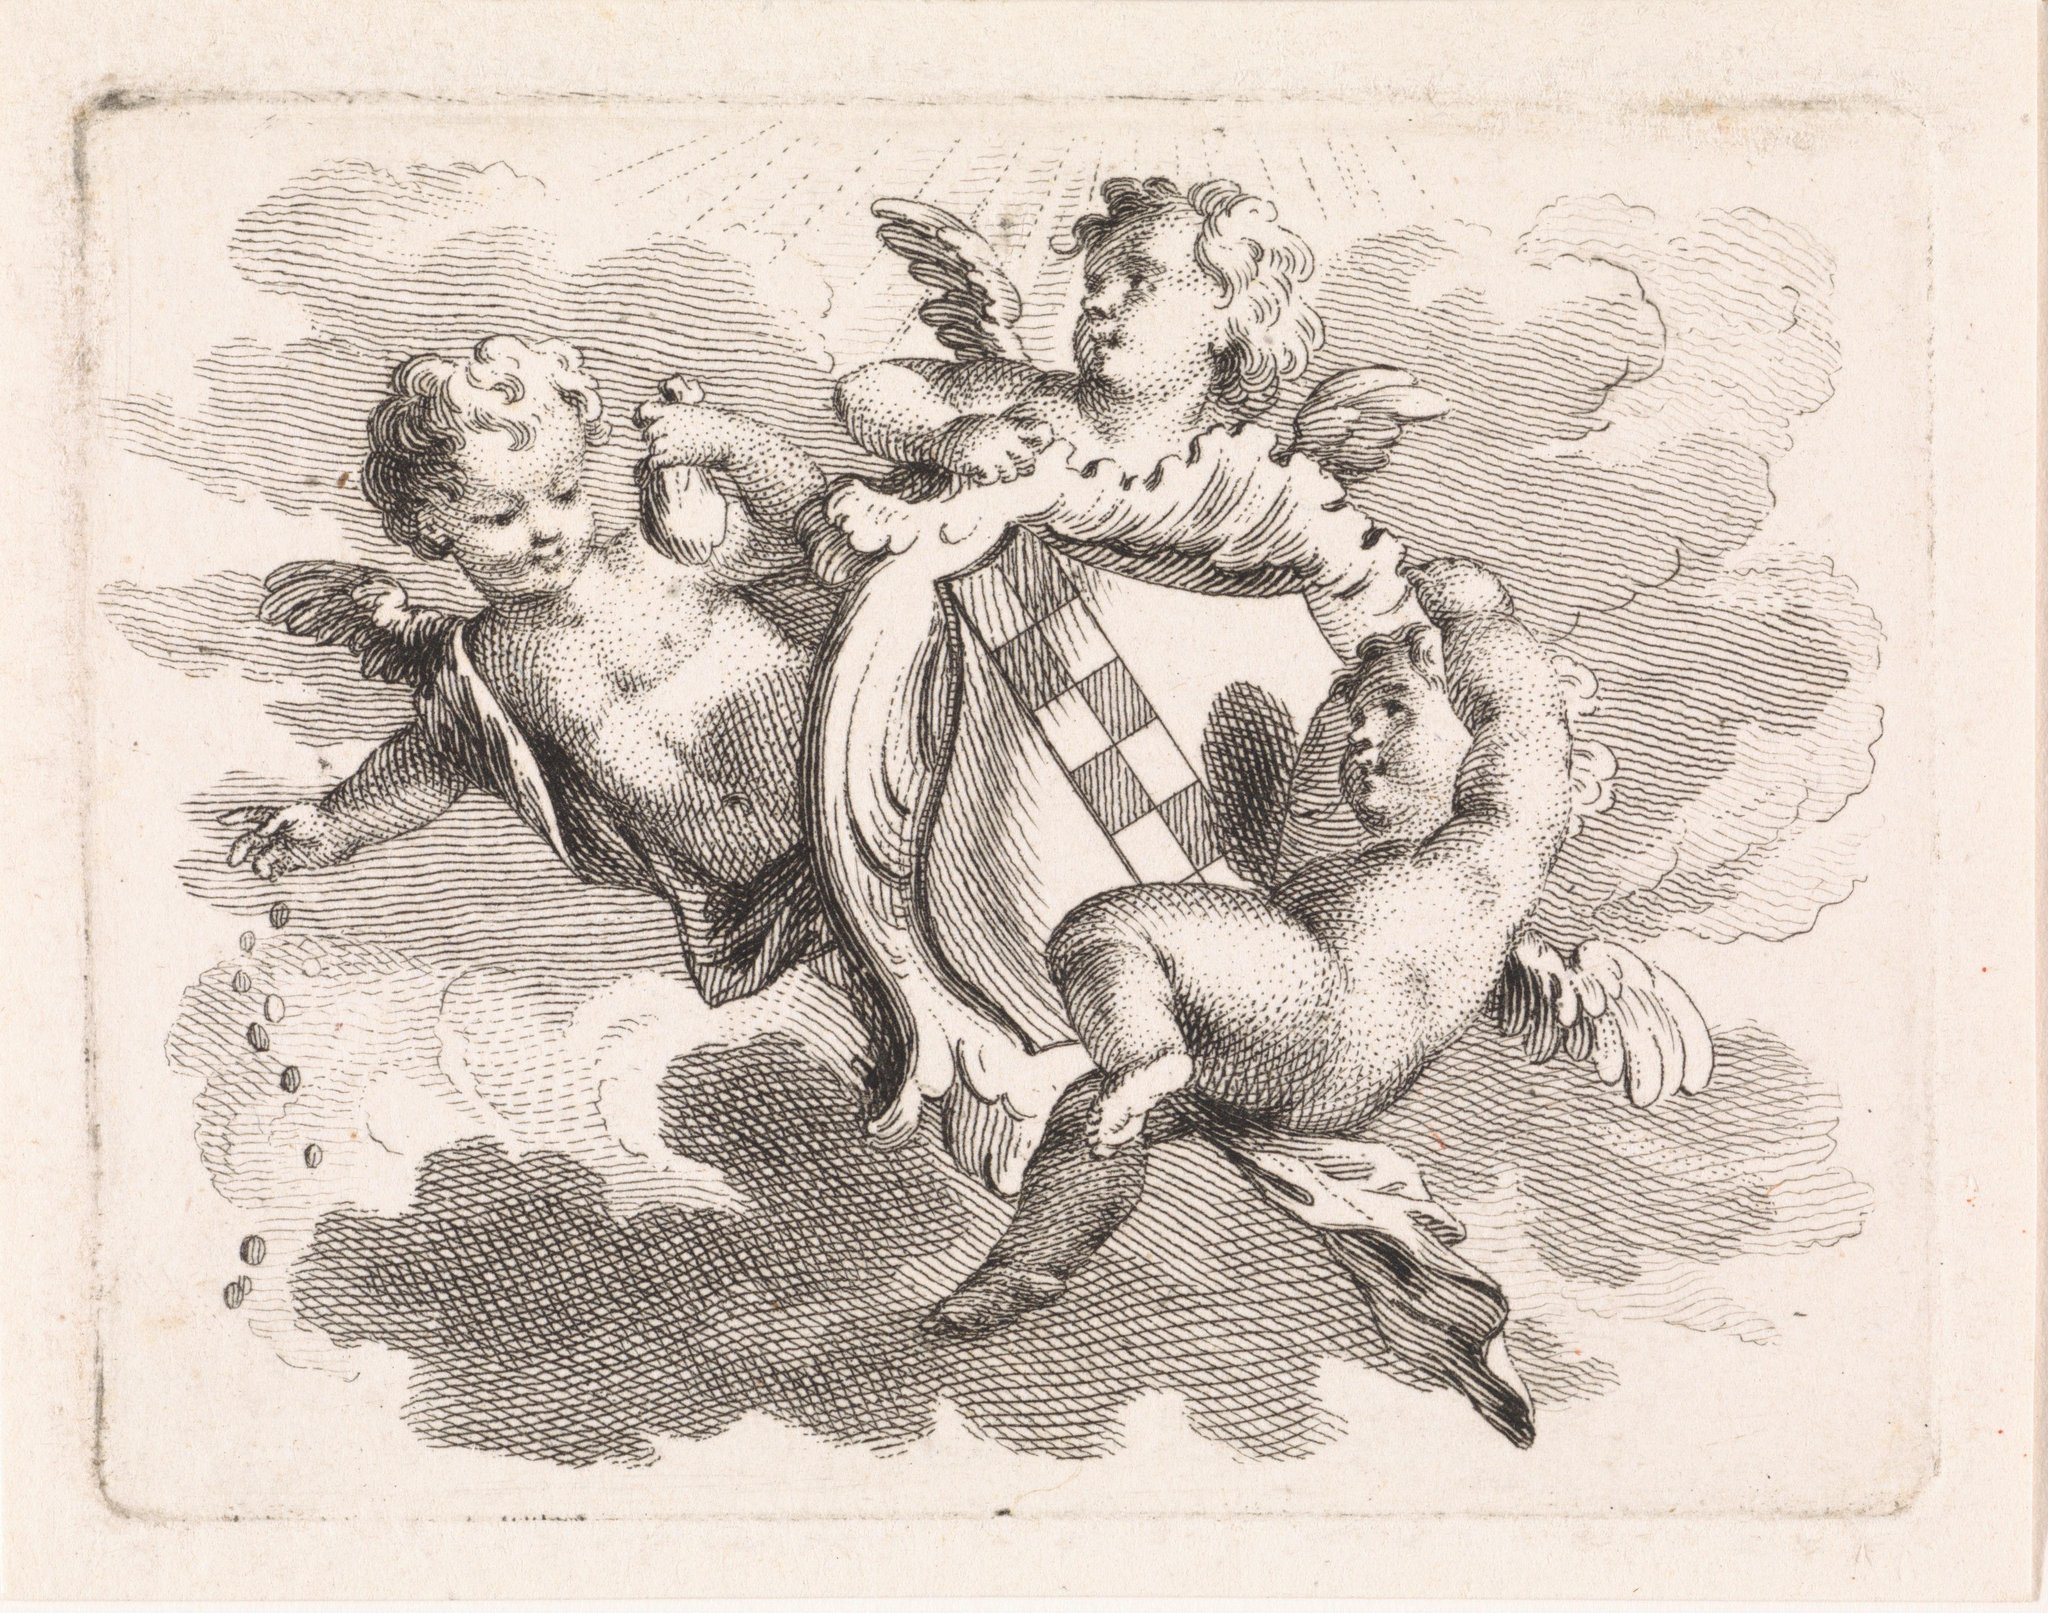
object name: print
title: Vignet met familiewapen, mogelijk van familie van Ruyven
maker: reinier vinkeles (i)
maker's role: draughtsman, print maker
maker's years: 1741-1816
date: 1751-1816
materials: paper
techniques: engraving, etching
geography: amsterdam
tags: cupids: 'amores', 'amoretti', 'putti', armorial bearing, heraldry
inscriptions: collector's mark: Lugt 240